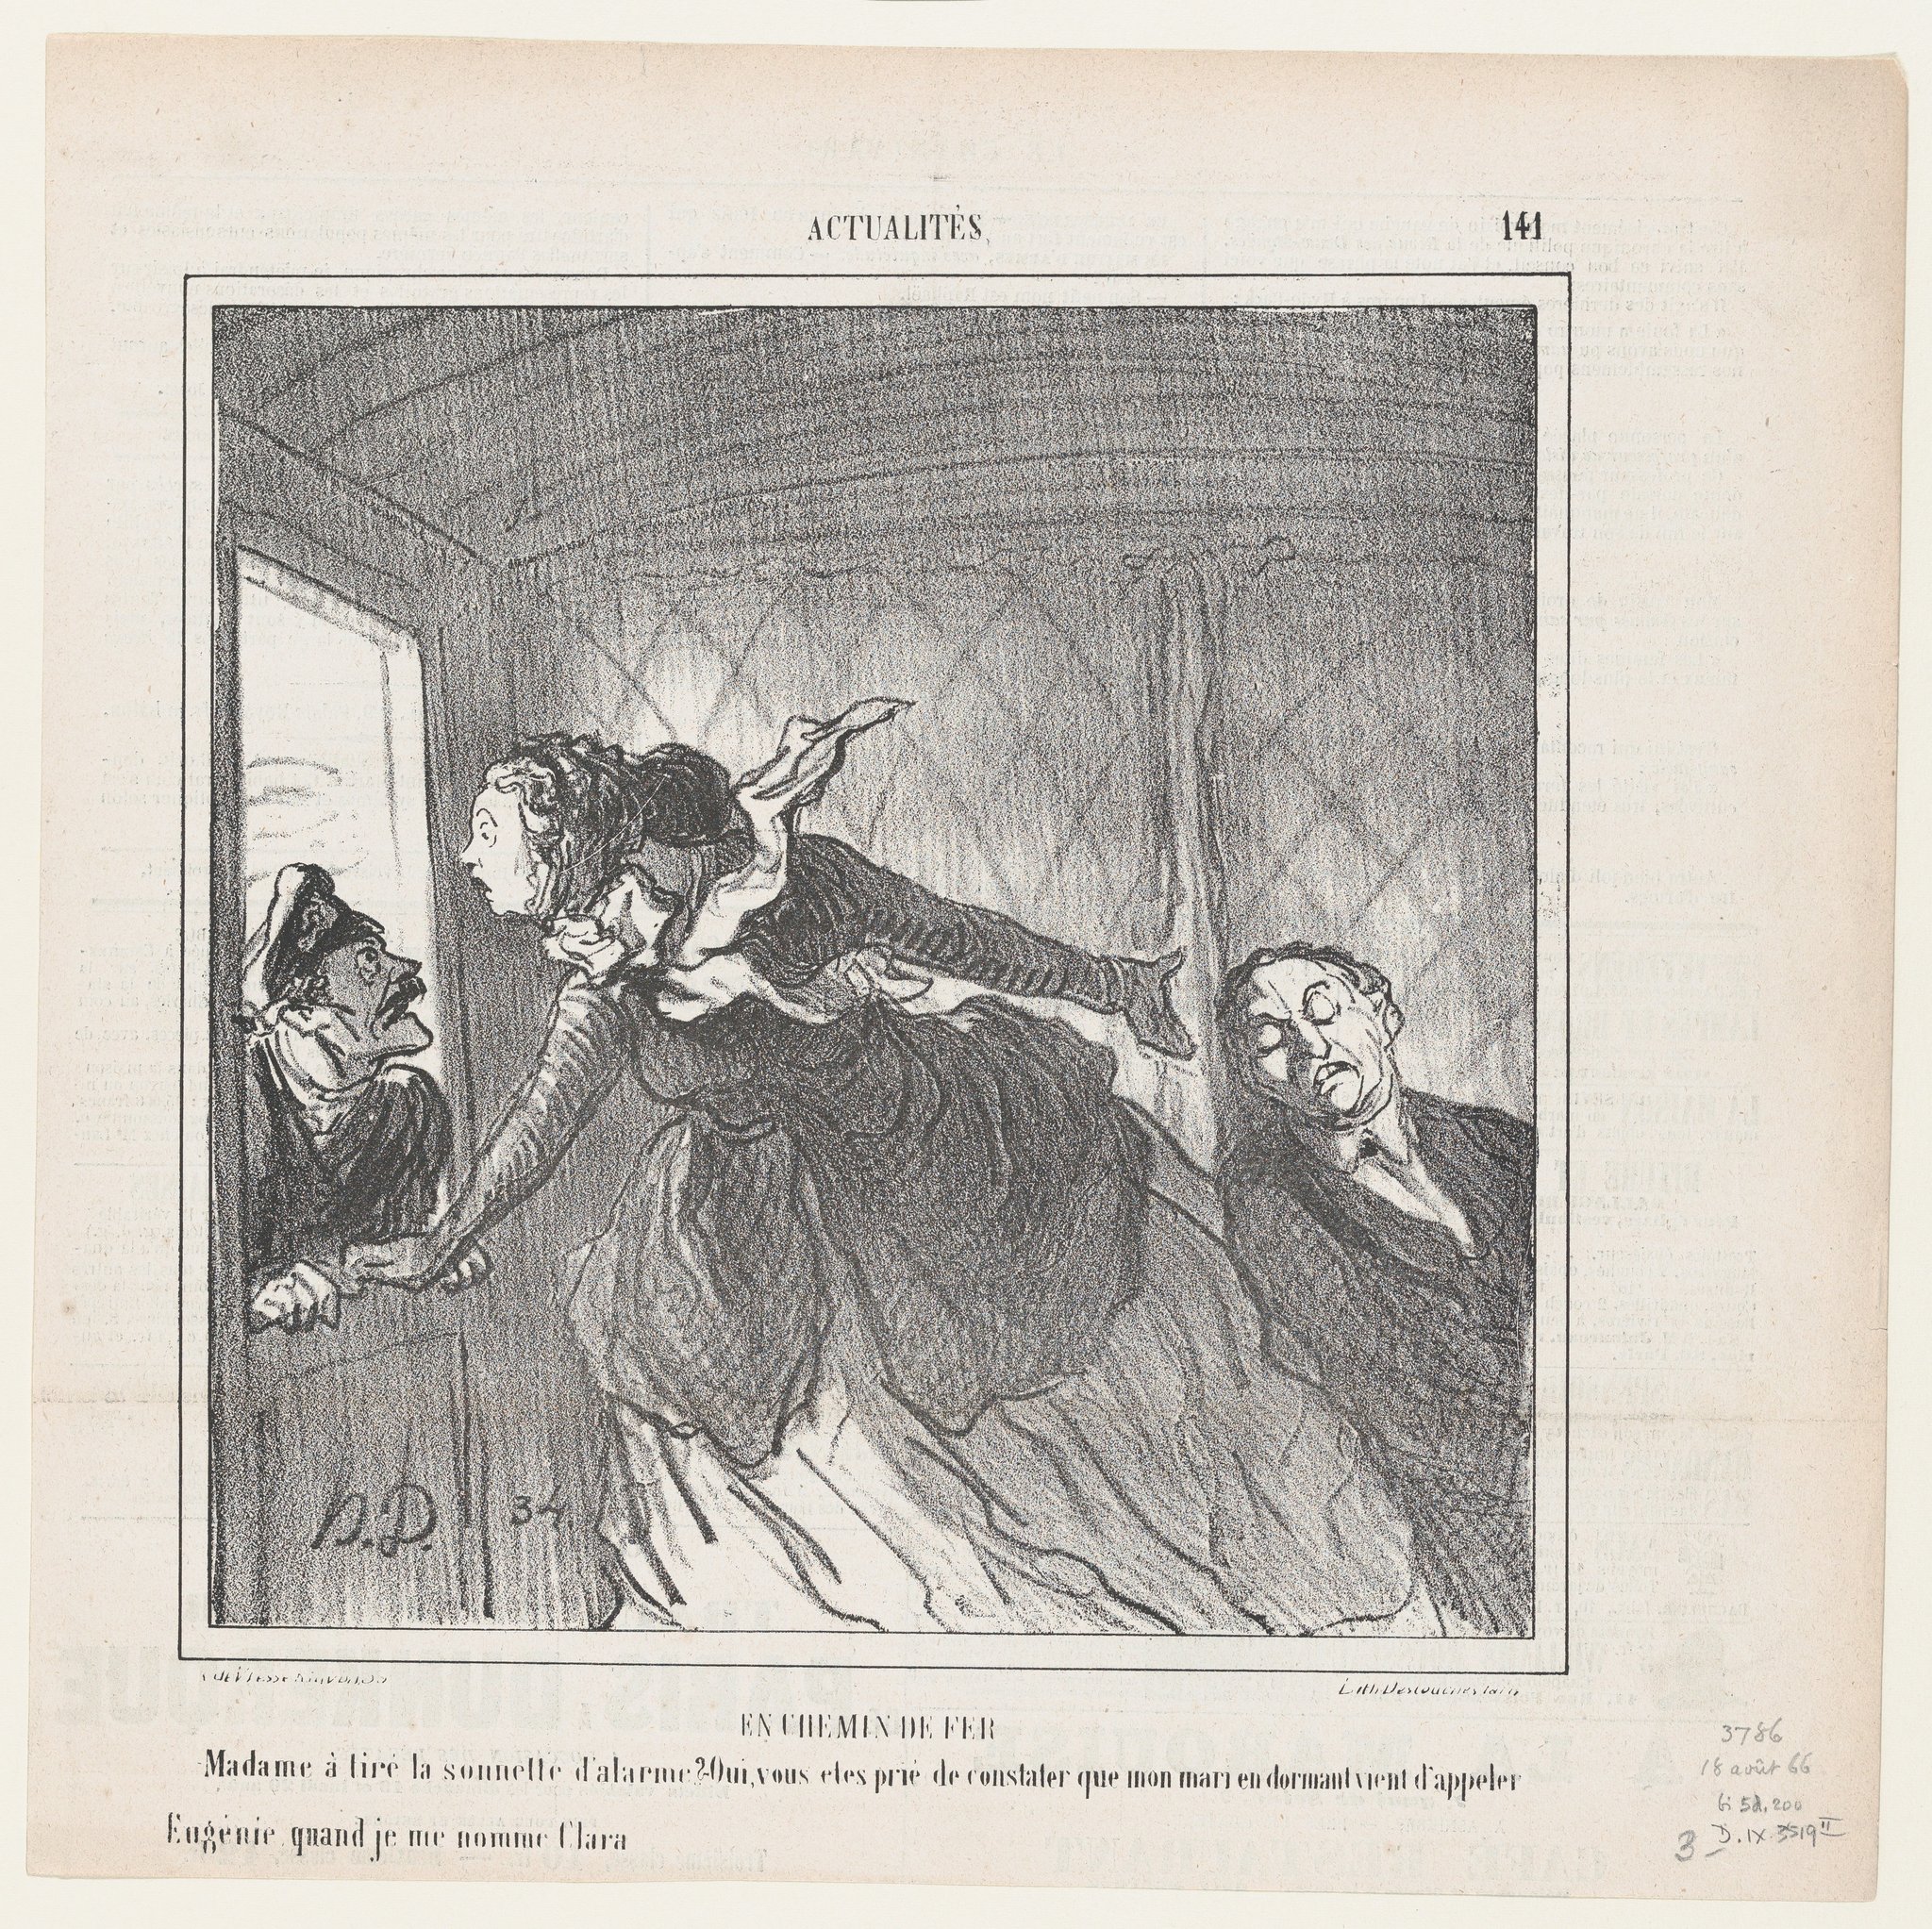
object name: print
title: On the railroad, from 'News of the day,' published in Le Charivari, August 18, 1866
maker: honoré daumier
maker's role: artist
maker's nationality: french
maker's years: 1808-1879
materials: paper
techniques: lithograph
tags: satire,men,women